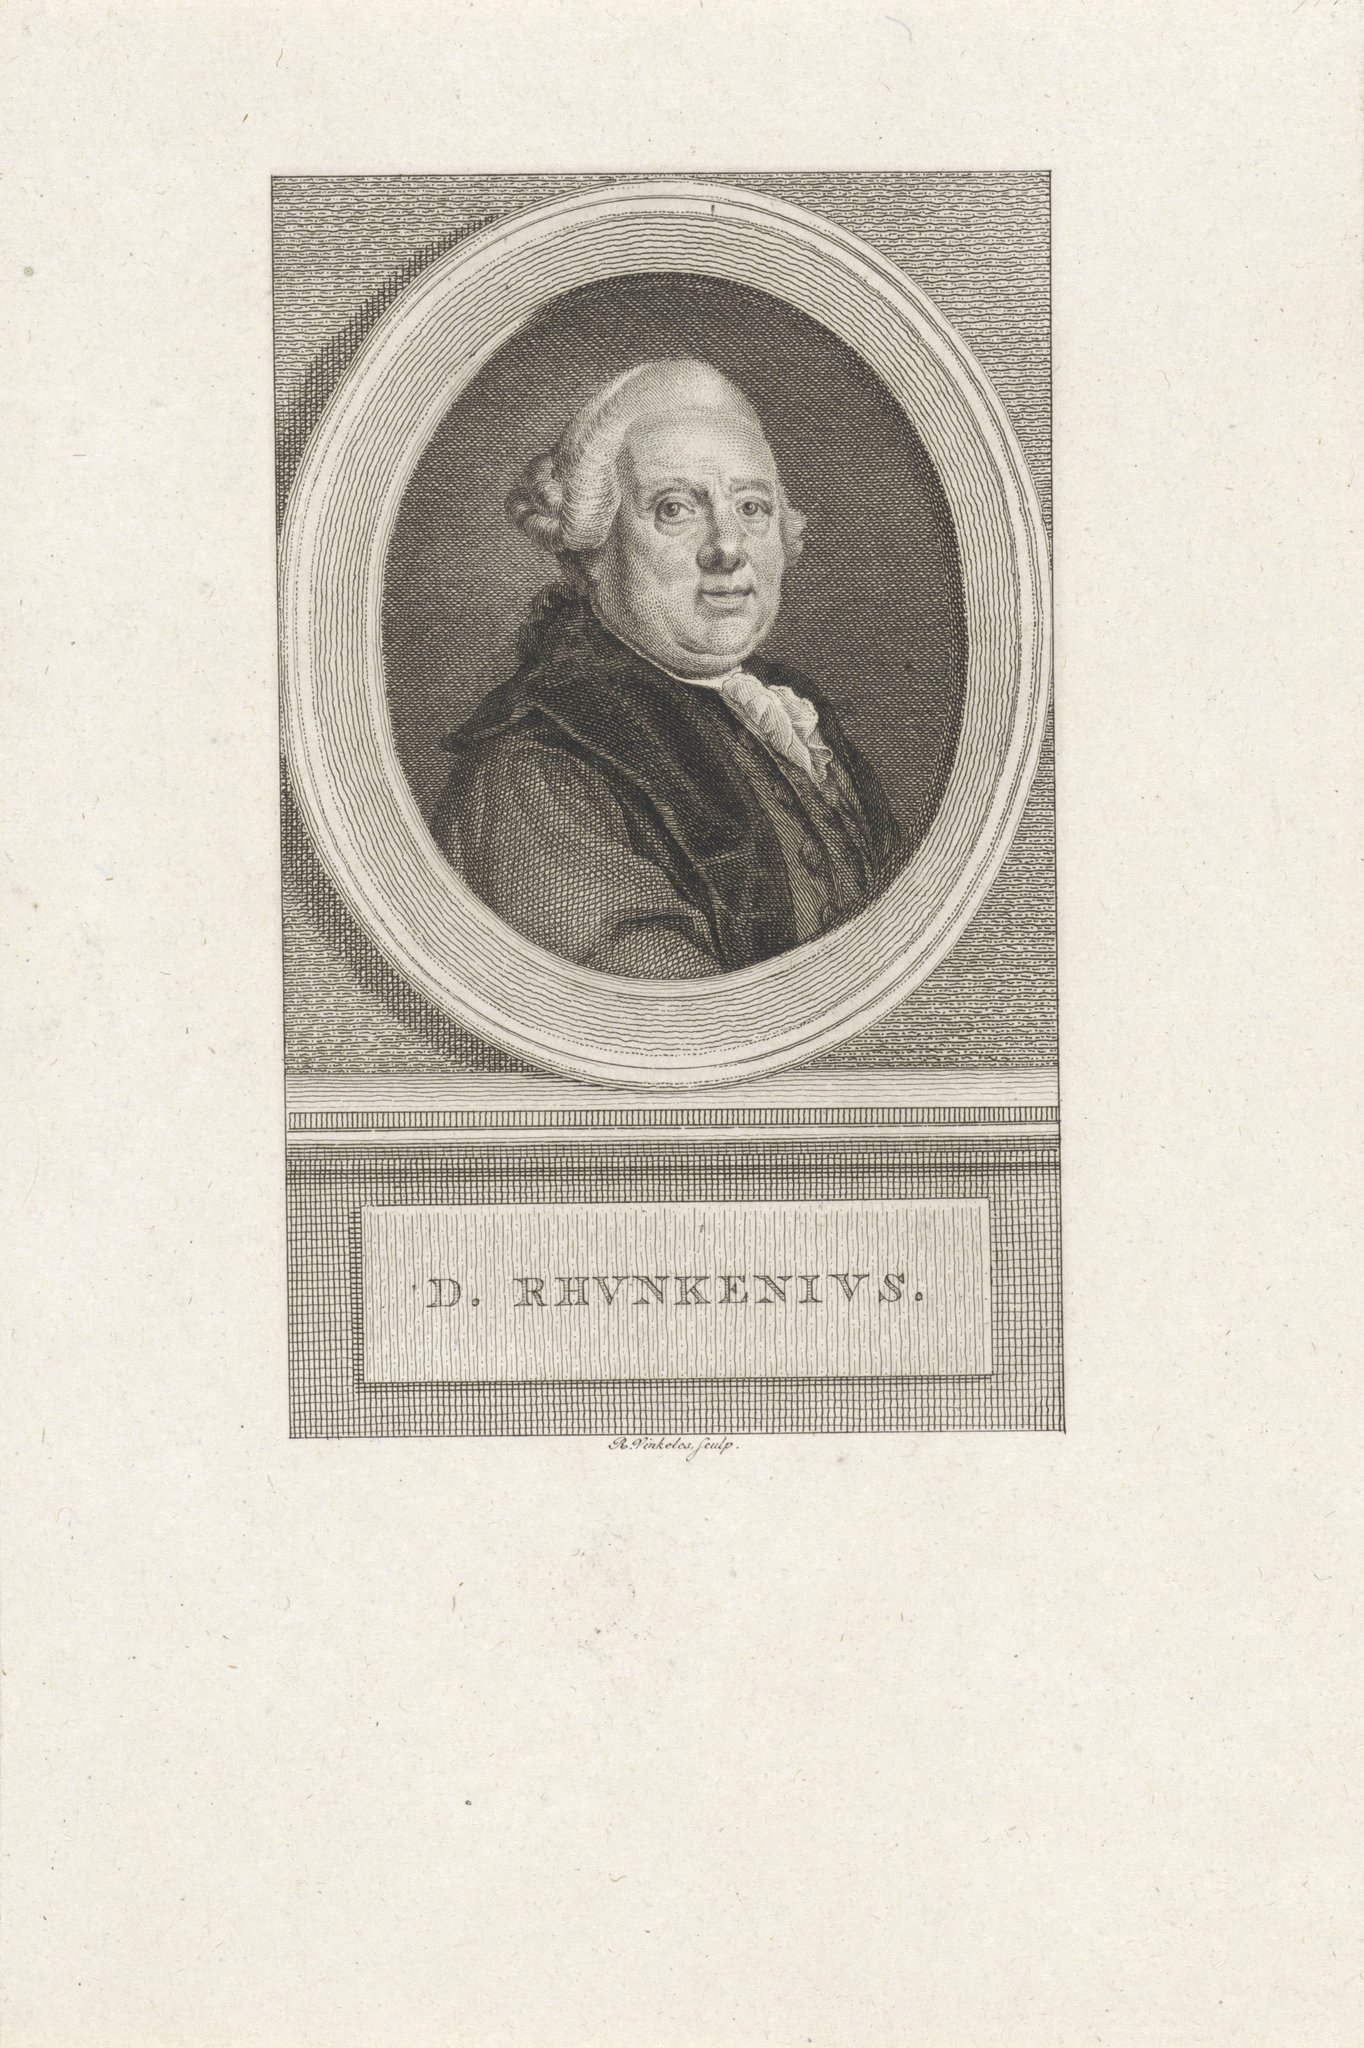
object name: print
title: Portret van David Ruhnken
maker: reinier vinkeles (i)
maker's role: draughtsman, print maker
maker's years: 1741-1816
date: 1786-1809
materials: paper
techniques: engraving, etching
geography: amsterdam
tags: leiden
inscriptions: collector's mark: Lugt 2228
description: Prent ook gebruikt als boekillustratie in: Wagenaar, Jan. Vaderlandsche historie, (...) ten vervolge van Wagenaars Vaderlandsche historie. Dl. 1-43. Amsterdam: Johannes Allart, 1786-1809.